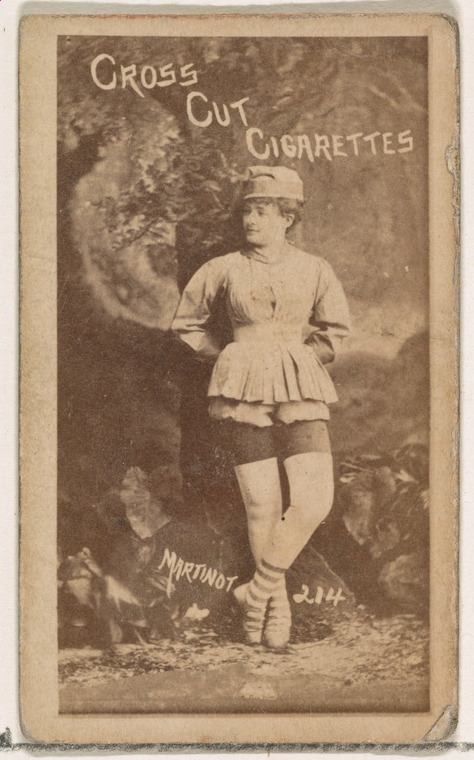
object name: print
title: Card Number 214, Sadie Martinot, from the Actors and Actresses series (N145-1) issued by Duke Sons & Co. to promote Cross Cut Cigarettes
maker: w. duke, sons & co.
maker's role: publisher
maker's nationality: american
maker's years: 1870-1920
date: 1880-1889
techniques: albumen silver print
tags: portraits,women,actresses